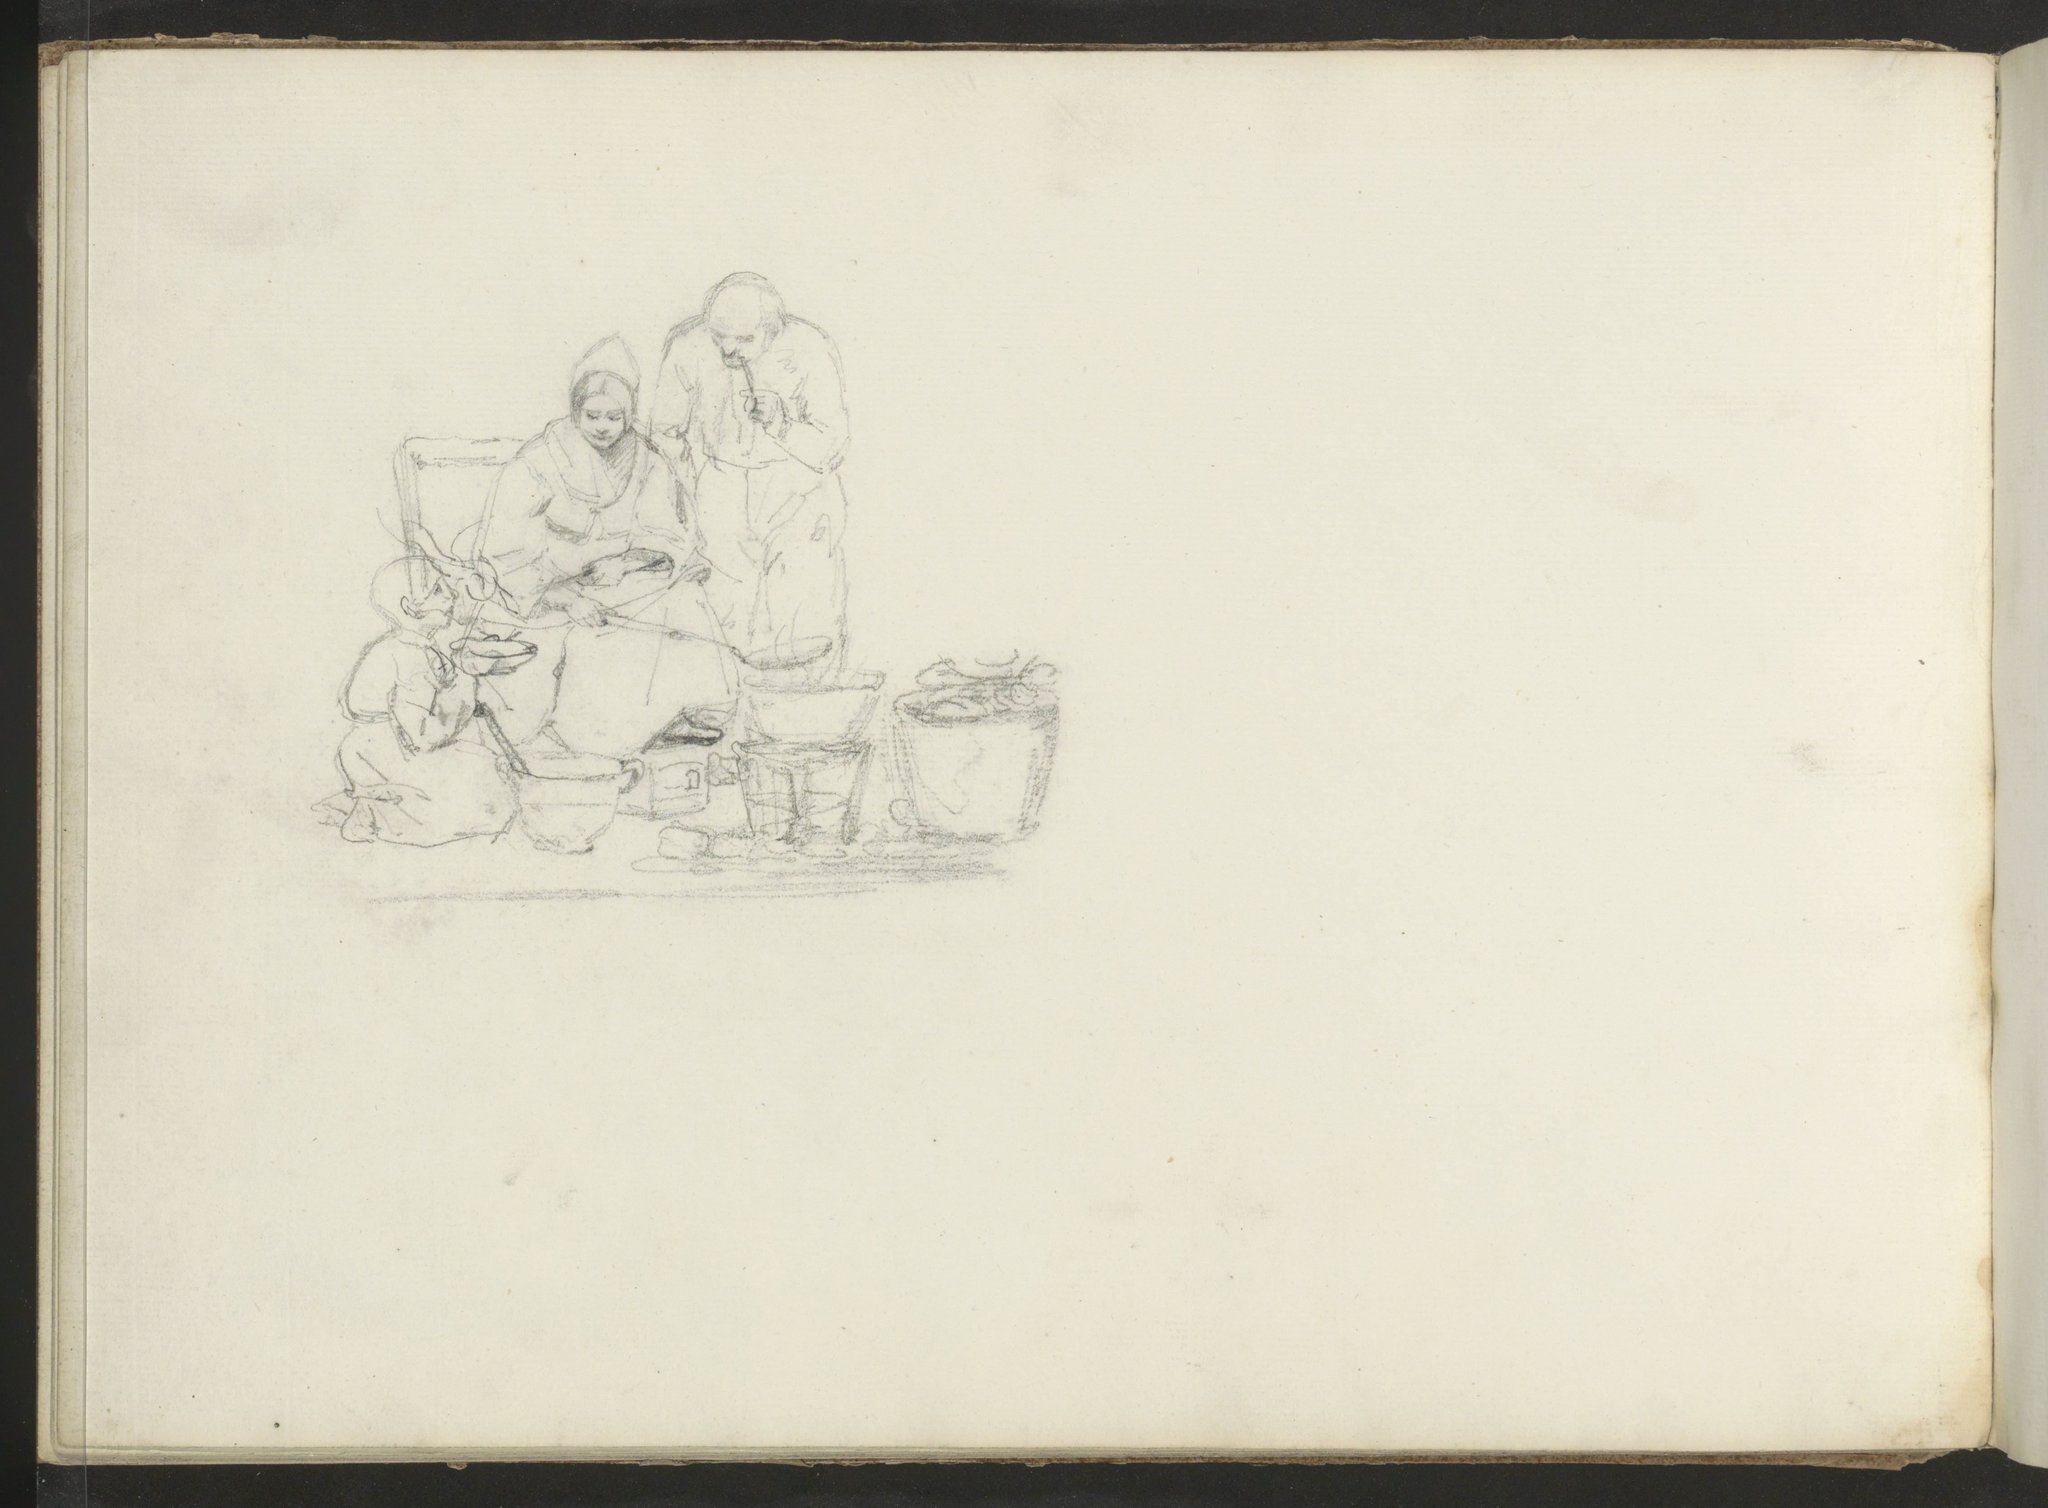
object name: sketchbook leaf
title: Boerengezin aan de maaltijd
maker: s. altmann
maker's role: painter, print maker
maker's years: 1822-1890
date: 1803-1840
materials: paper, pencil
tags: (family) meal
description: Een vrouw schept met een lepel eten uit een pan. Naast haar staat een oude man met een pijp en zit een kind met een schaal in de handen. Blad 11 verso uit een schetsboek met 24 bladen.